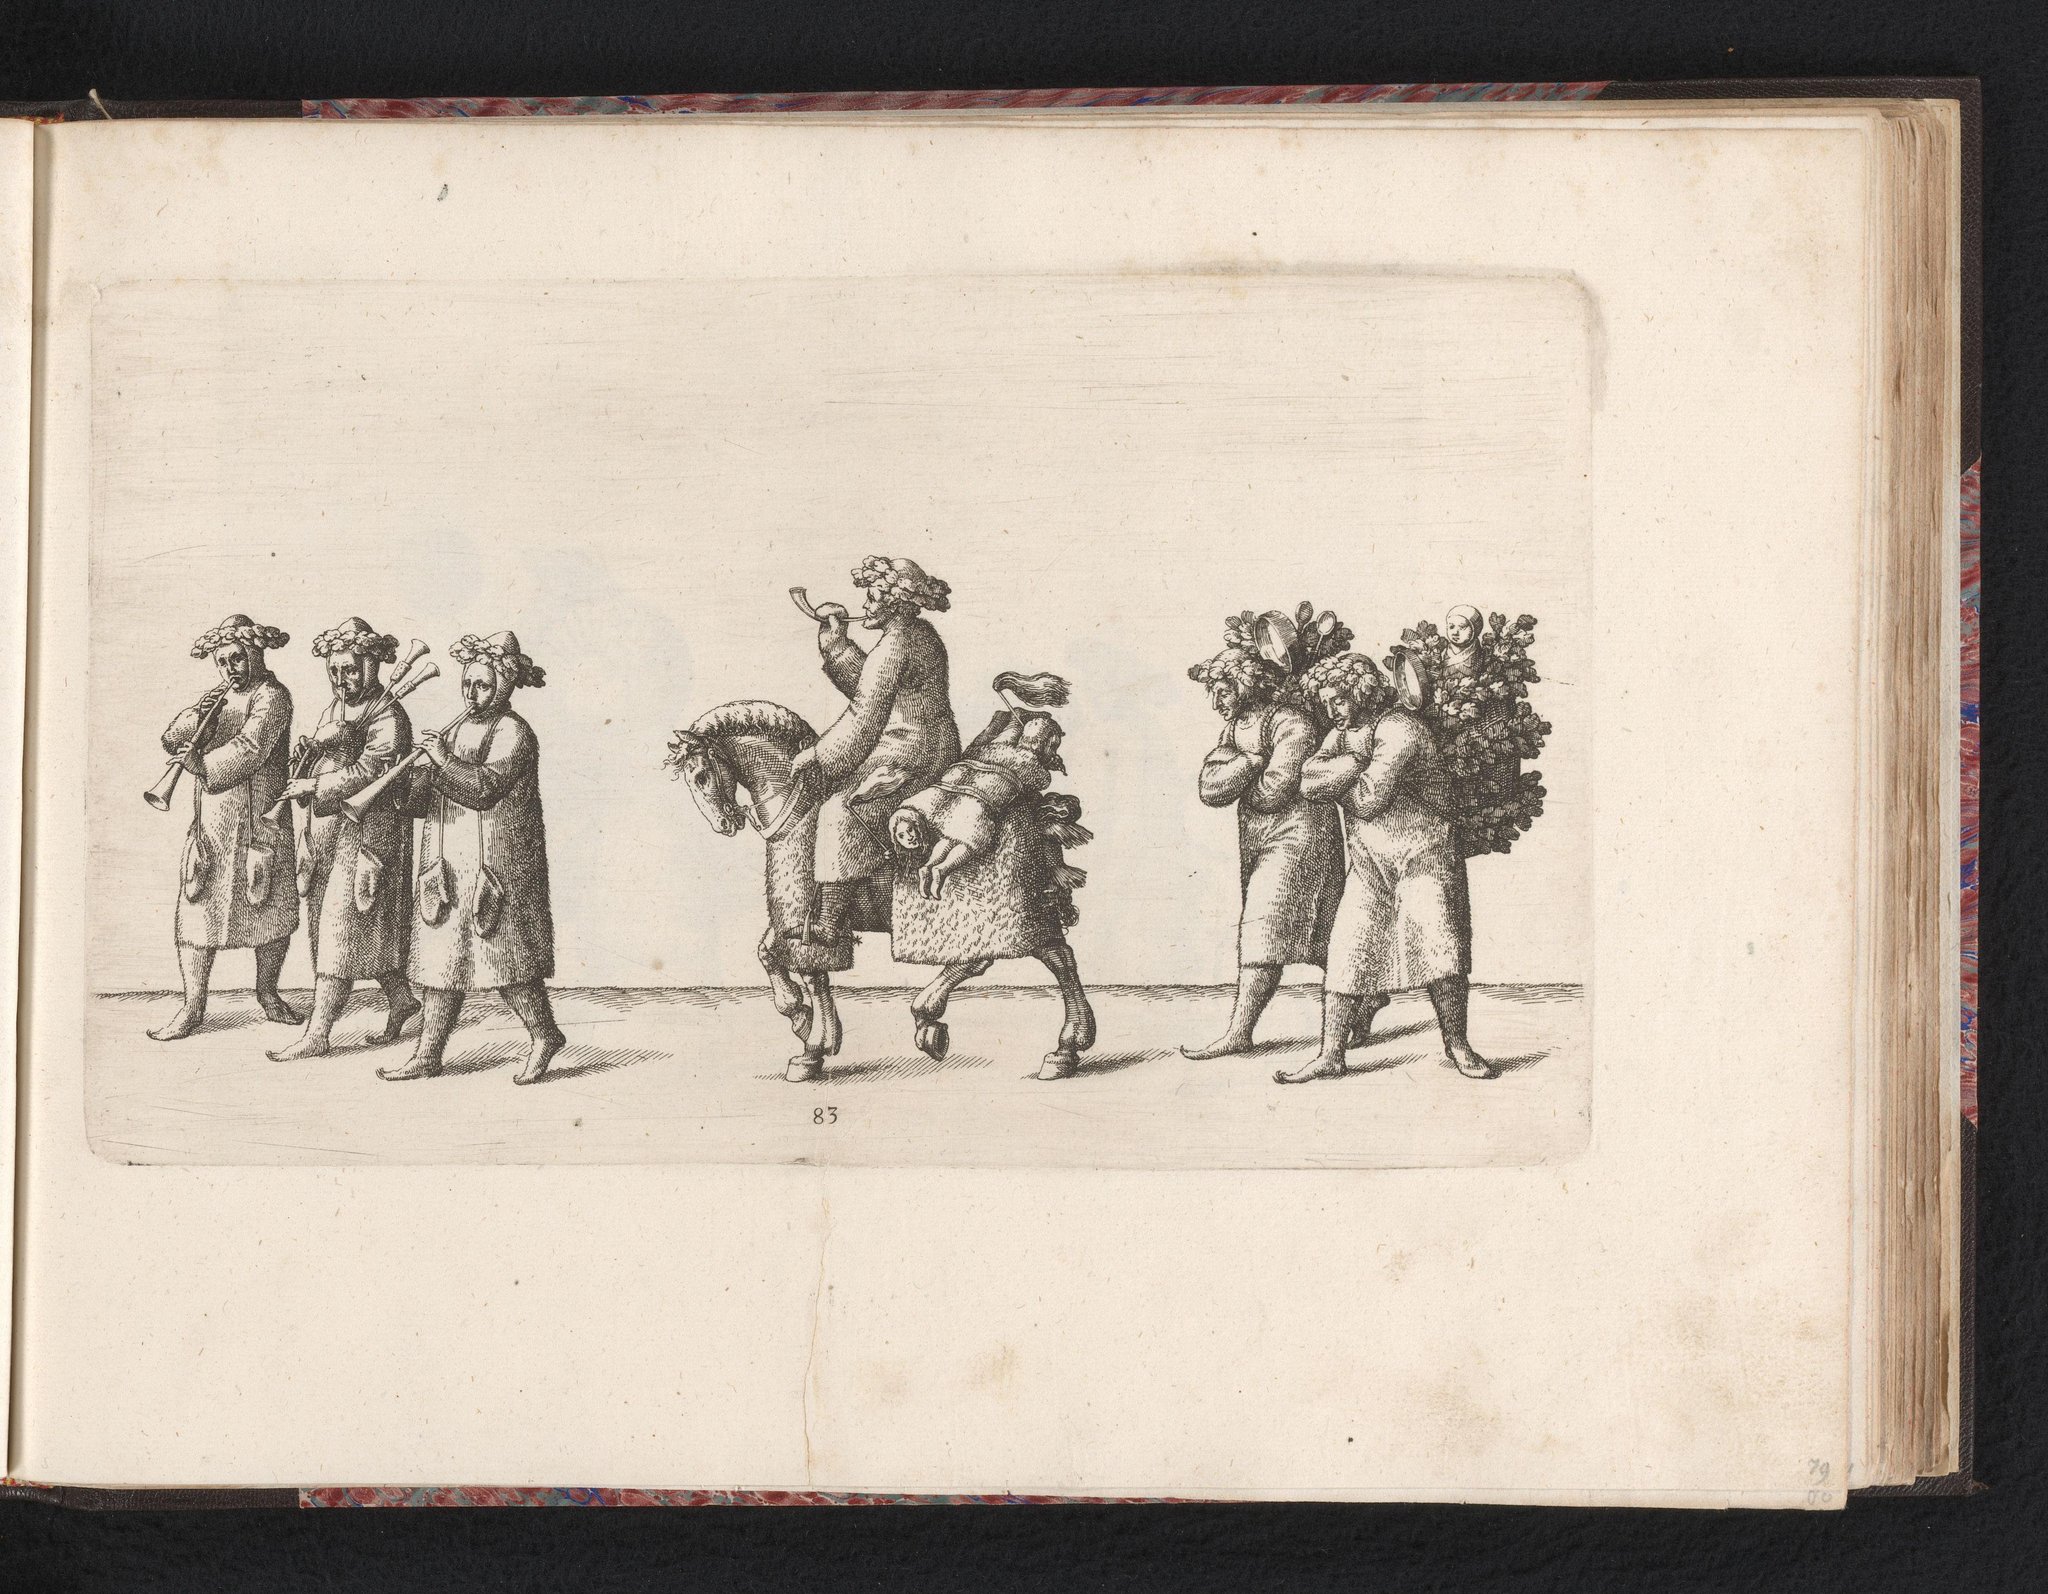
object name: print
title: Drie muzikanten, ruiter met vastgebonden kinderen en twee figuren met manden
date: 1618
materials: paper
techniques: etching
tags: musician - cc - out of doors, carrying something in basket, bag, rucksack, etc., performance in the open air (pleasure fair), kidnapping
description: Genummerd: 83. Deze prent maakt deel uit van een album.